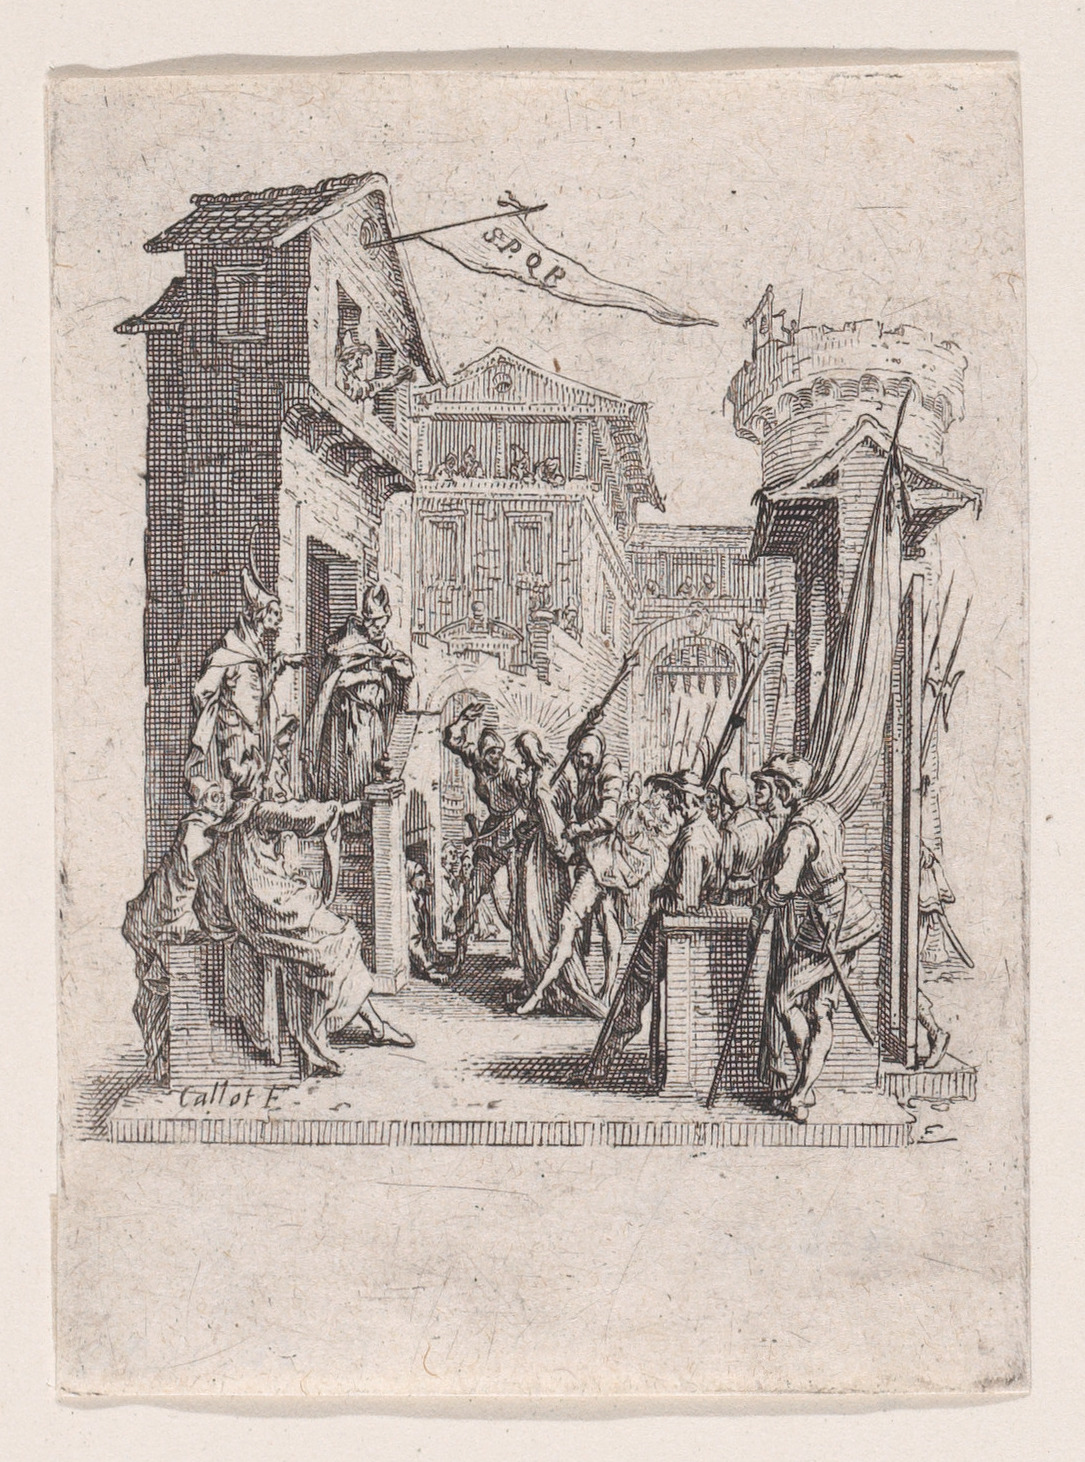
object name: print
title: Jésus Comparait Devant Caiphe (Jesus Appears Before Caiaphas), from "La Petite Passion" (The Little Passion)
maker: jacques callot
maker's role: artist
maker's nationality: french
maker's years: 1592-1635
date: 1624-1625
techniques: etching